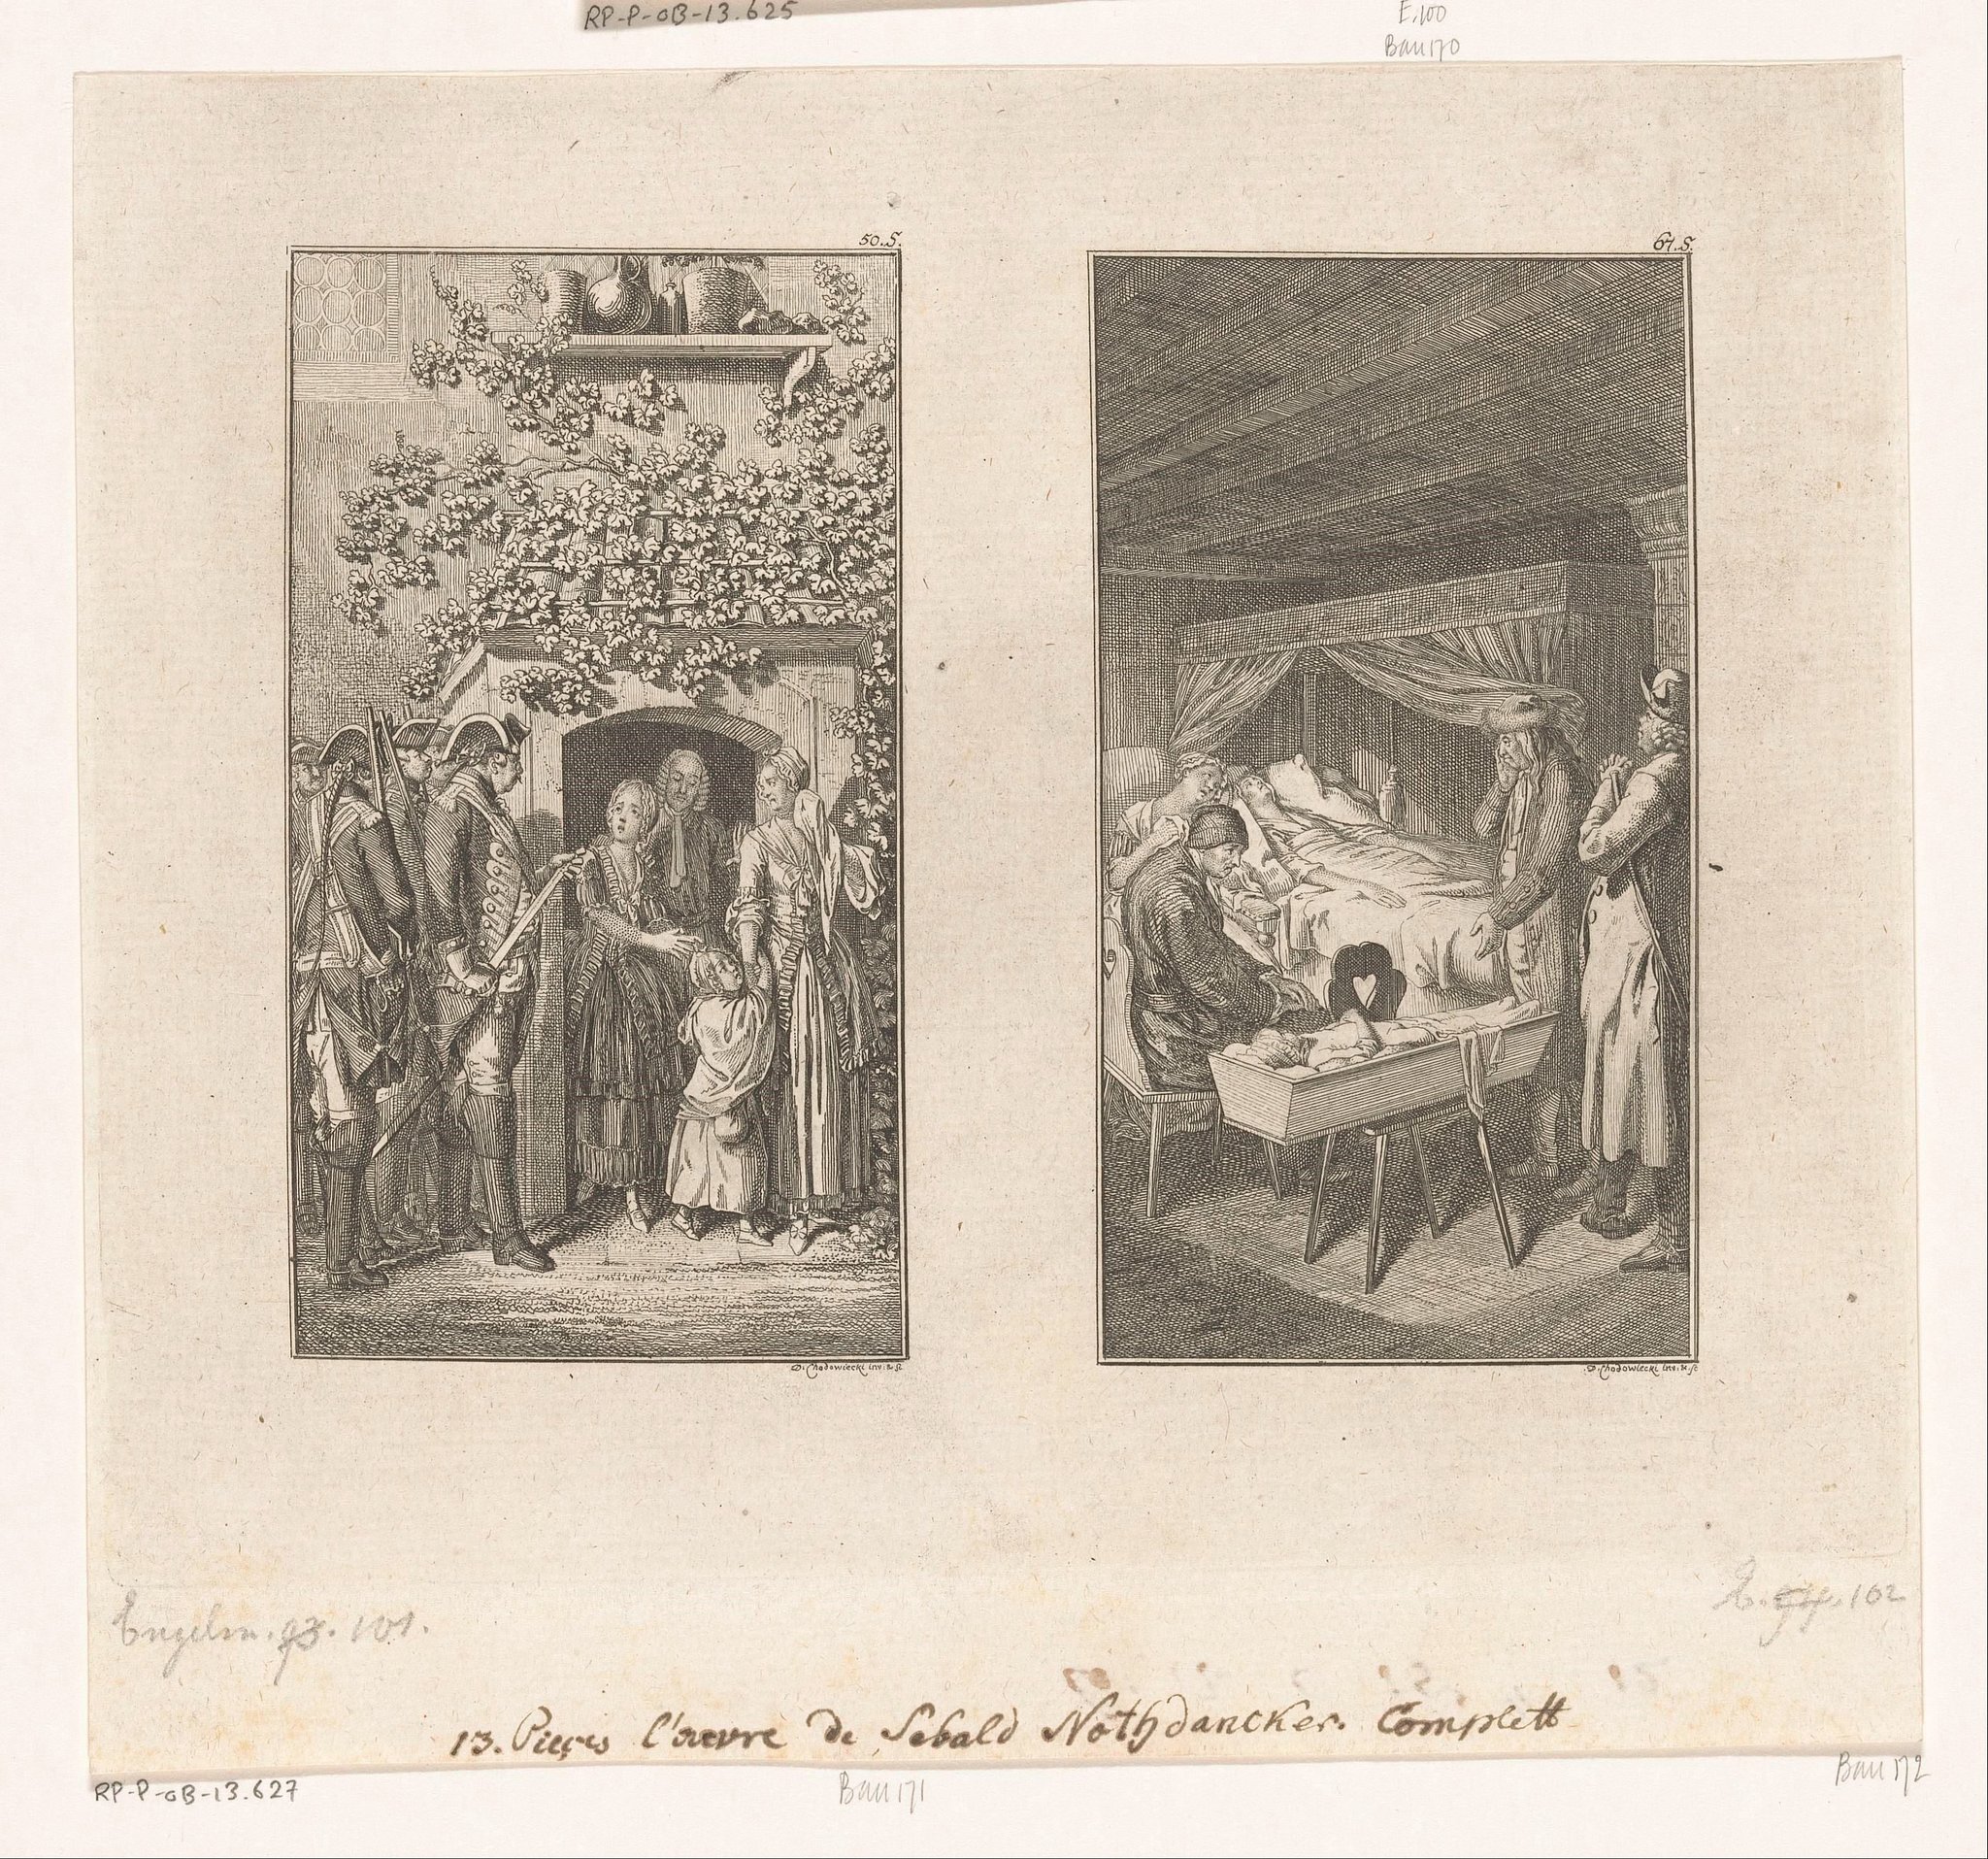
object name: print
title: Twee scènes uit Sebaldus Nothanker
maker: daniel nikolaus chodowiecki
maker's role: draughtsman, print maker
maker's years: 1726-1801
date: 1773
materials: paper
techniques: etching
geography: berlin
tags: berlin, publisher, friedrich nicolai, literature, suspension, expulsion (from a society), deathbed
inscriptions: inscription: ‘lot 13 C 15 # 12’, collector's mark: Lugt 240, inscription: ‘13. Pieces l'oeuvre de Sebald Nothdancker Complett’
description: Deze scènes behoren tot een serie prenten die het verhaal van Sebaldus Nothanker door Friedrich Nicolai illustreren. Voor een nieuwe editie van dit werk werd deze scène opnieuw in prent gebracht door Chodowiecki, waarschijnlijk vanwege slijtage aan de eerder gebruikte plaat (vergelijk RP-P-OB-13.621). De eerste staat van deze prenten is gebruikt in: [Nicolai Friedrich]. Das Leben und die Meinungen des Herrn Magister Sebaldus Nothanker. Berlijn en Stettin: Friedrich Nicolai, 1774 [tweede editie], dl. 1.